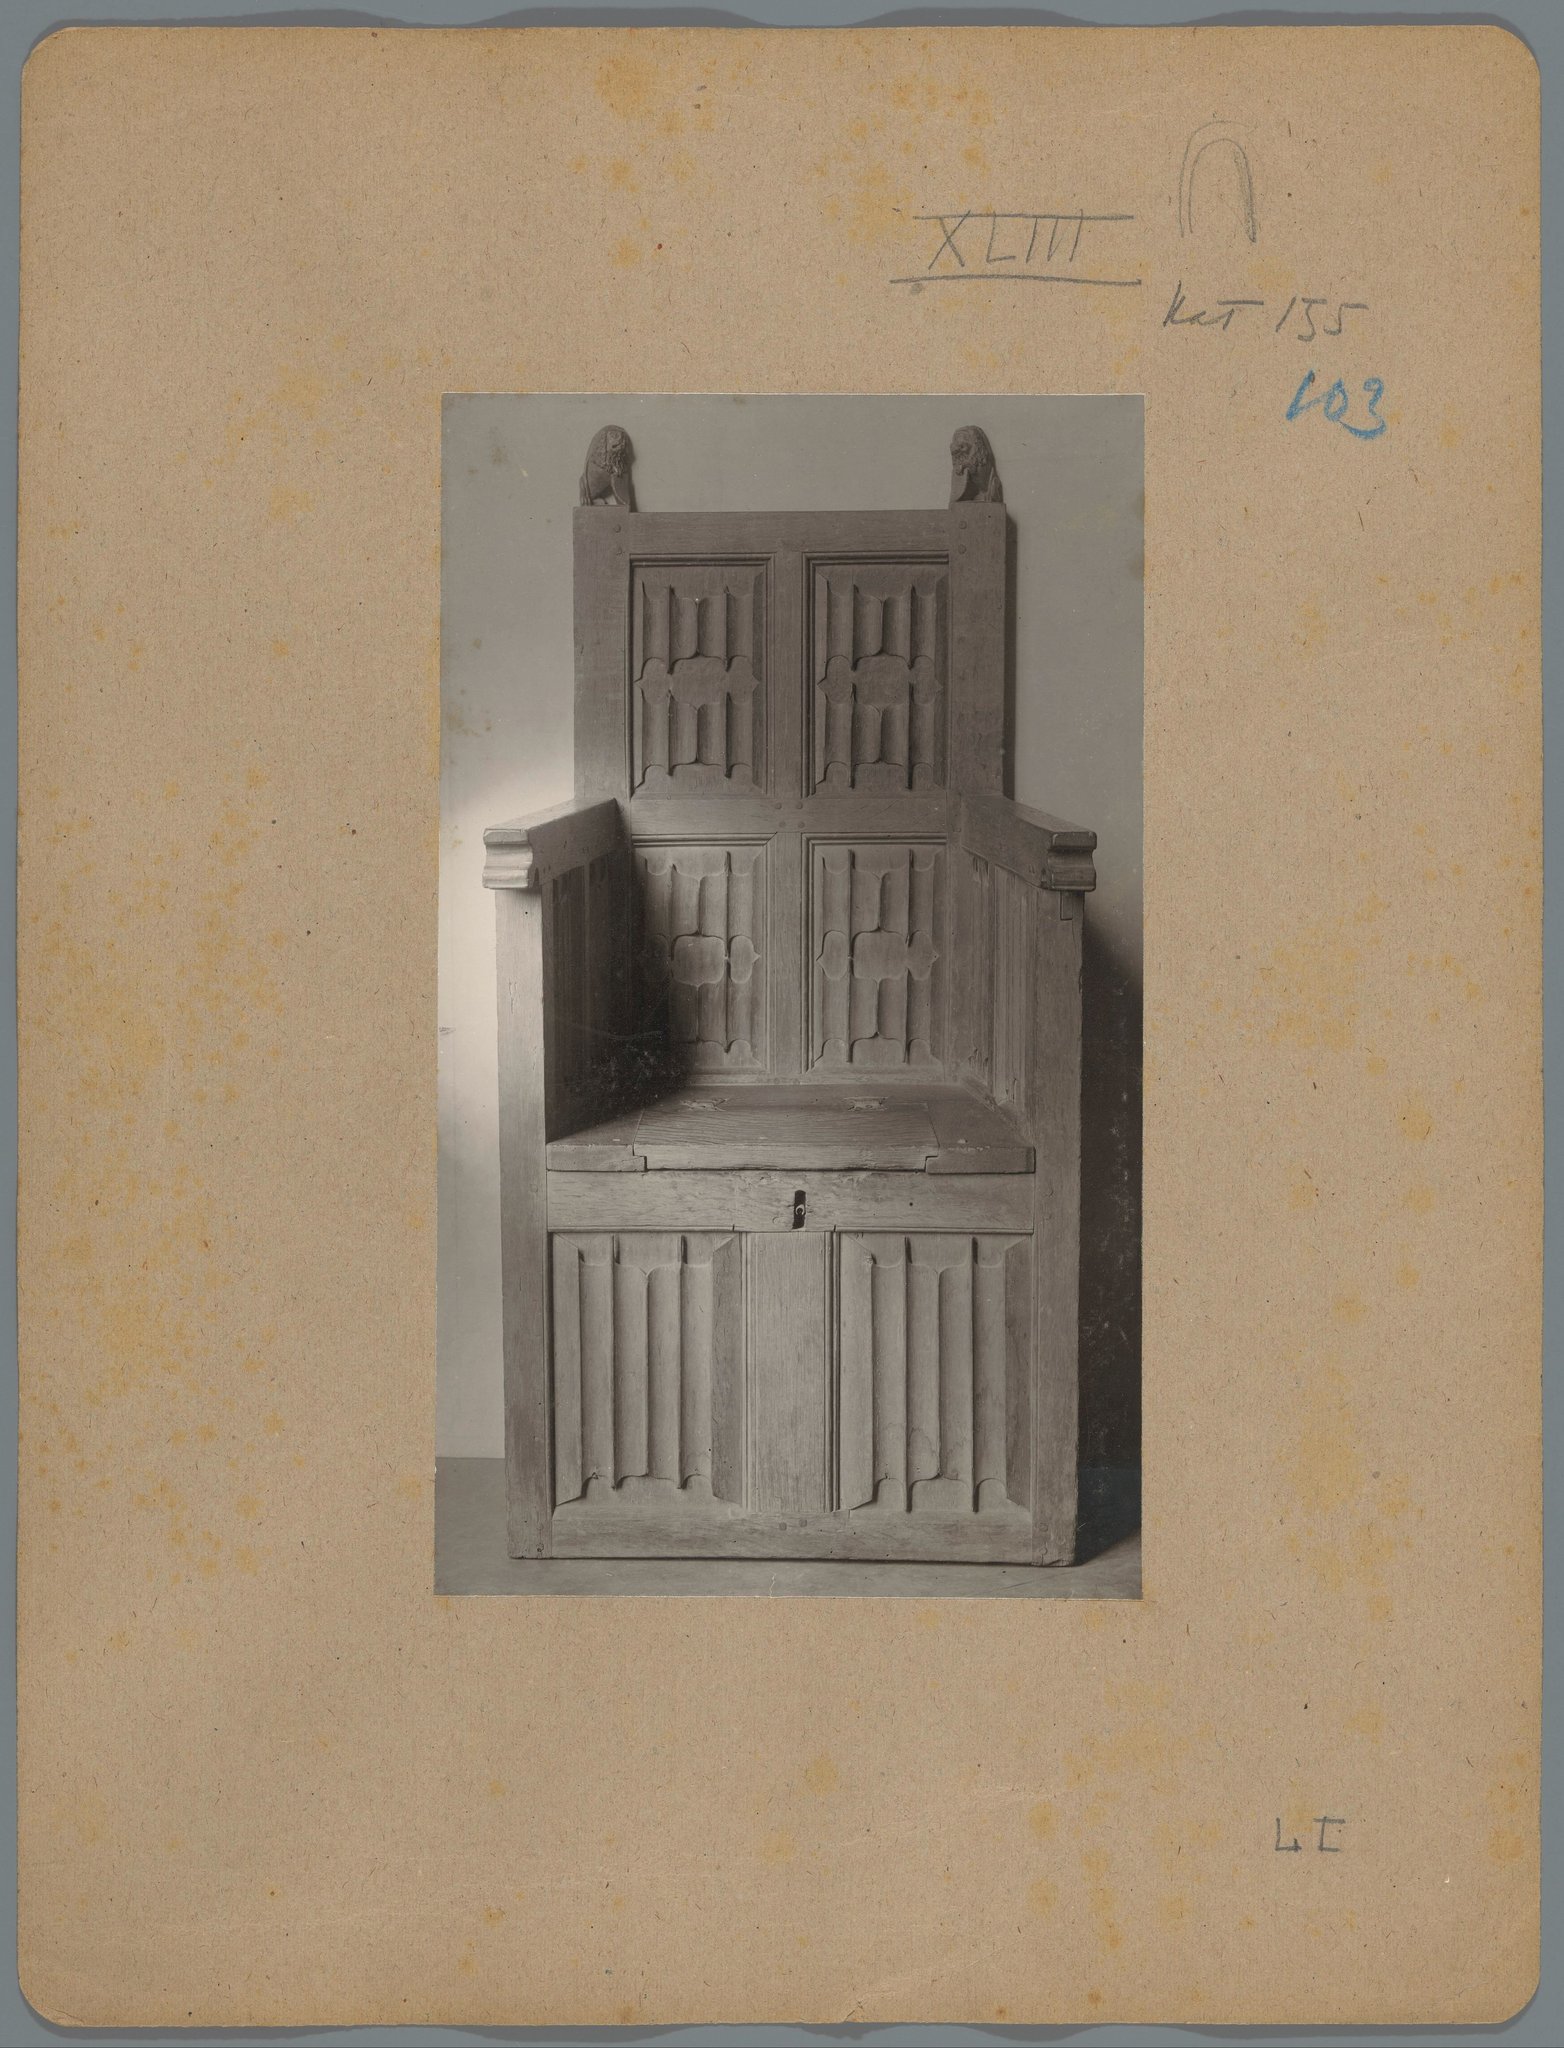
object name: photograph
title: Armstoel met kistvormig onderstel, versierd met briefpanelen en koppen van de achterstijlen in de vorm van schilddragende leeuwen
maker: Anonymous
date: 1875-1900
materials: cardboard, photographic support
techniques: gelatin silver print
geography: amsterdam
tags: armchair, seat, lion's head ~ ornament, amsterdam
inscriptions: number: ‘XLIII’, number: ‘Kat 155’, collector's mark: ‘KUNSTNIJVERHEIDSCHOOL QUELLINUS AMSTERDAM FRANS HALSSTRAAT 14.’, number: ‘103’, collector's mark: ‘INSTITUUT VOOR KUNST-NIJVERHEIDSONDERWIJS GABRIËL METSUSTRAAT No. 16 AMSTERDAM’